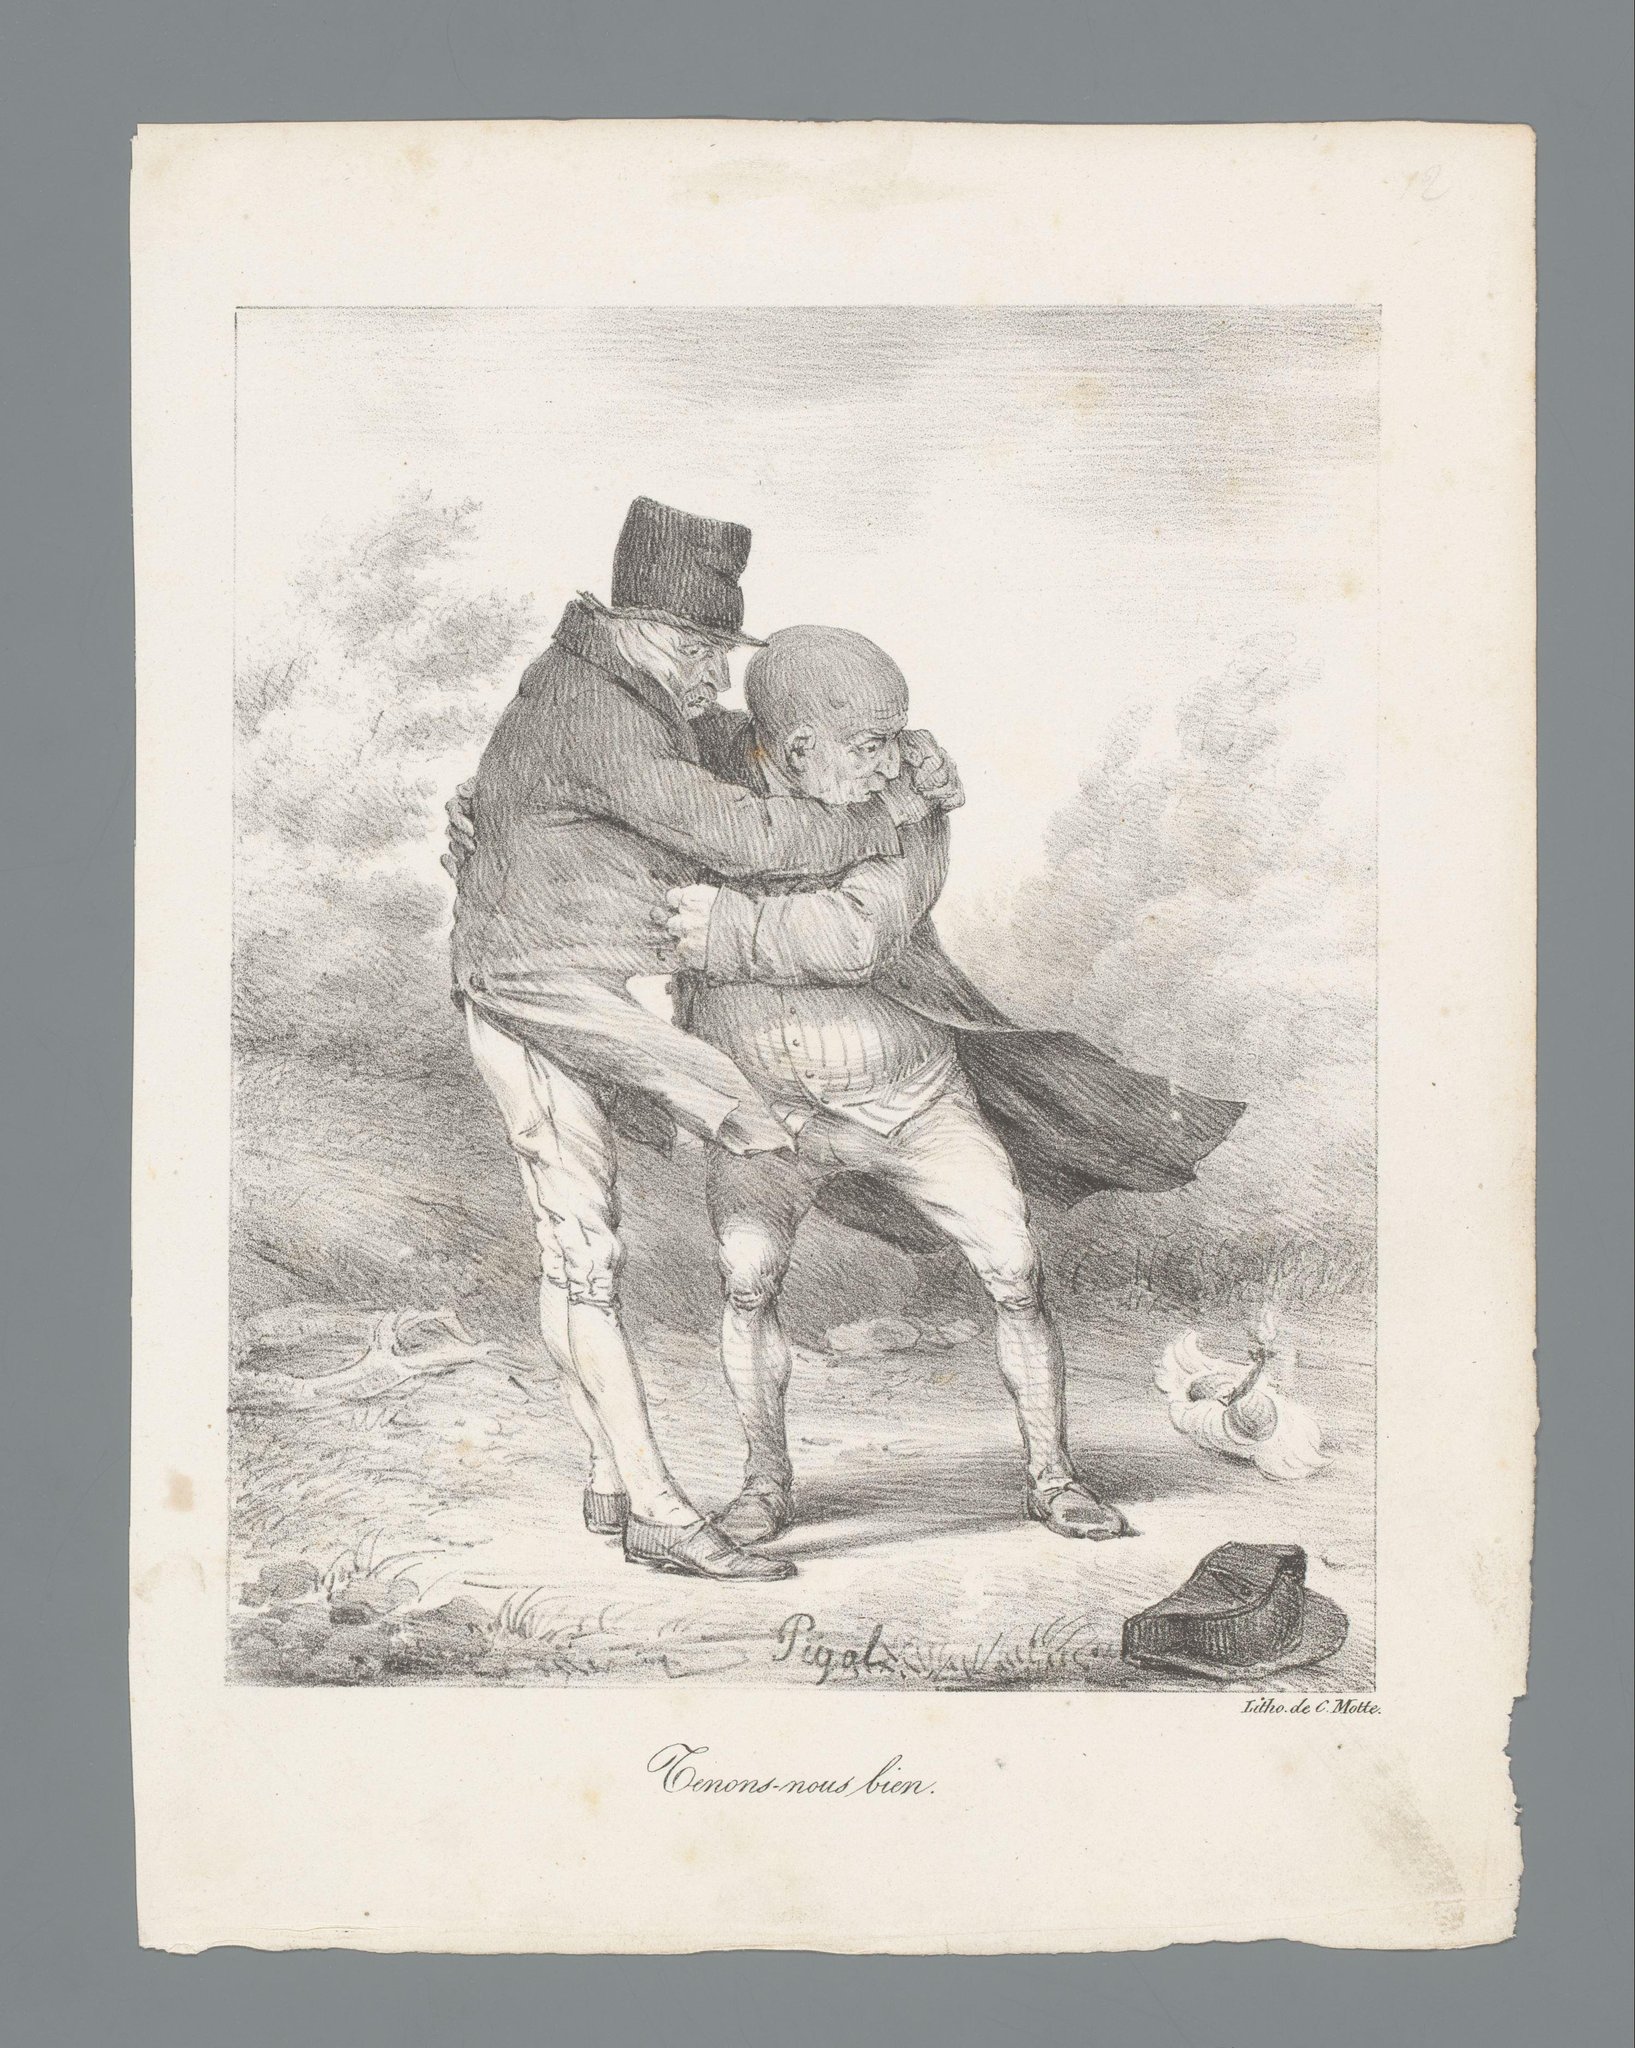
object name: print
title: Twee mannen houden elkaar stevig vast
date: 1823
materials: paper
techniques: lithograph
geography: paris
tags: adult man ( + one person)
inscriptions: collector's mark: Lugt 2228